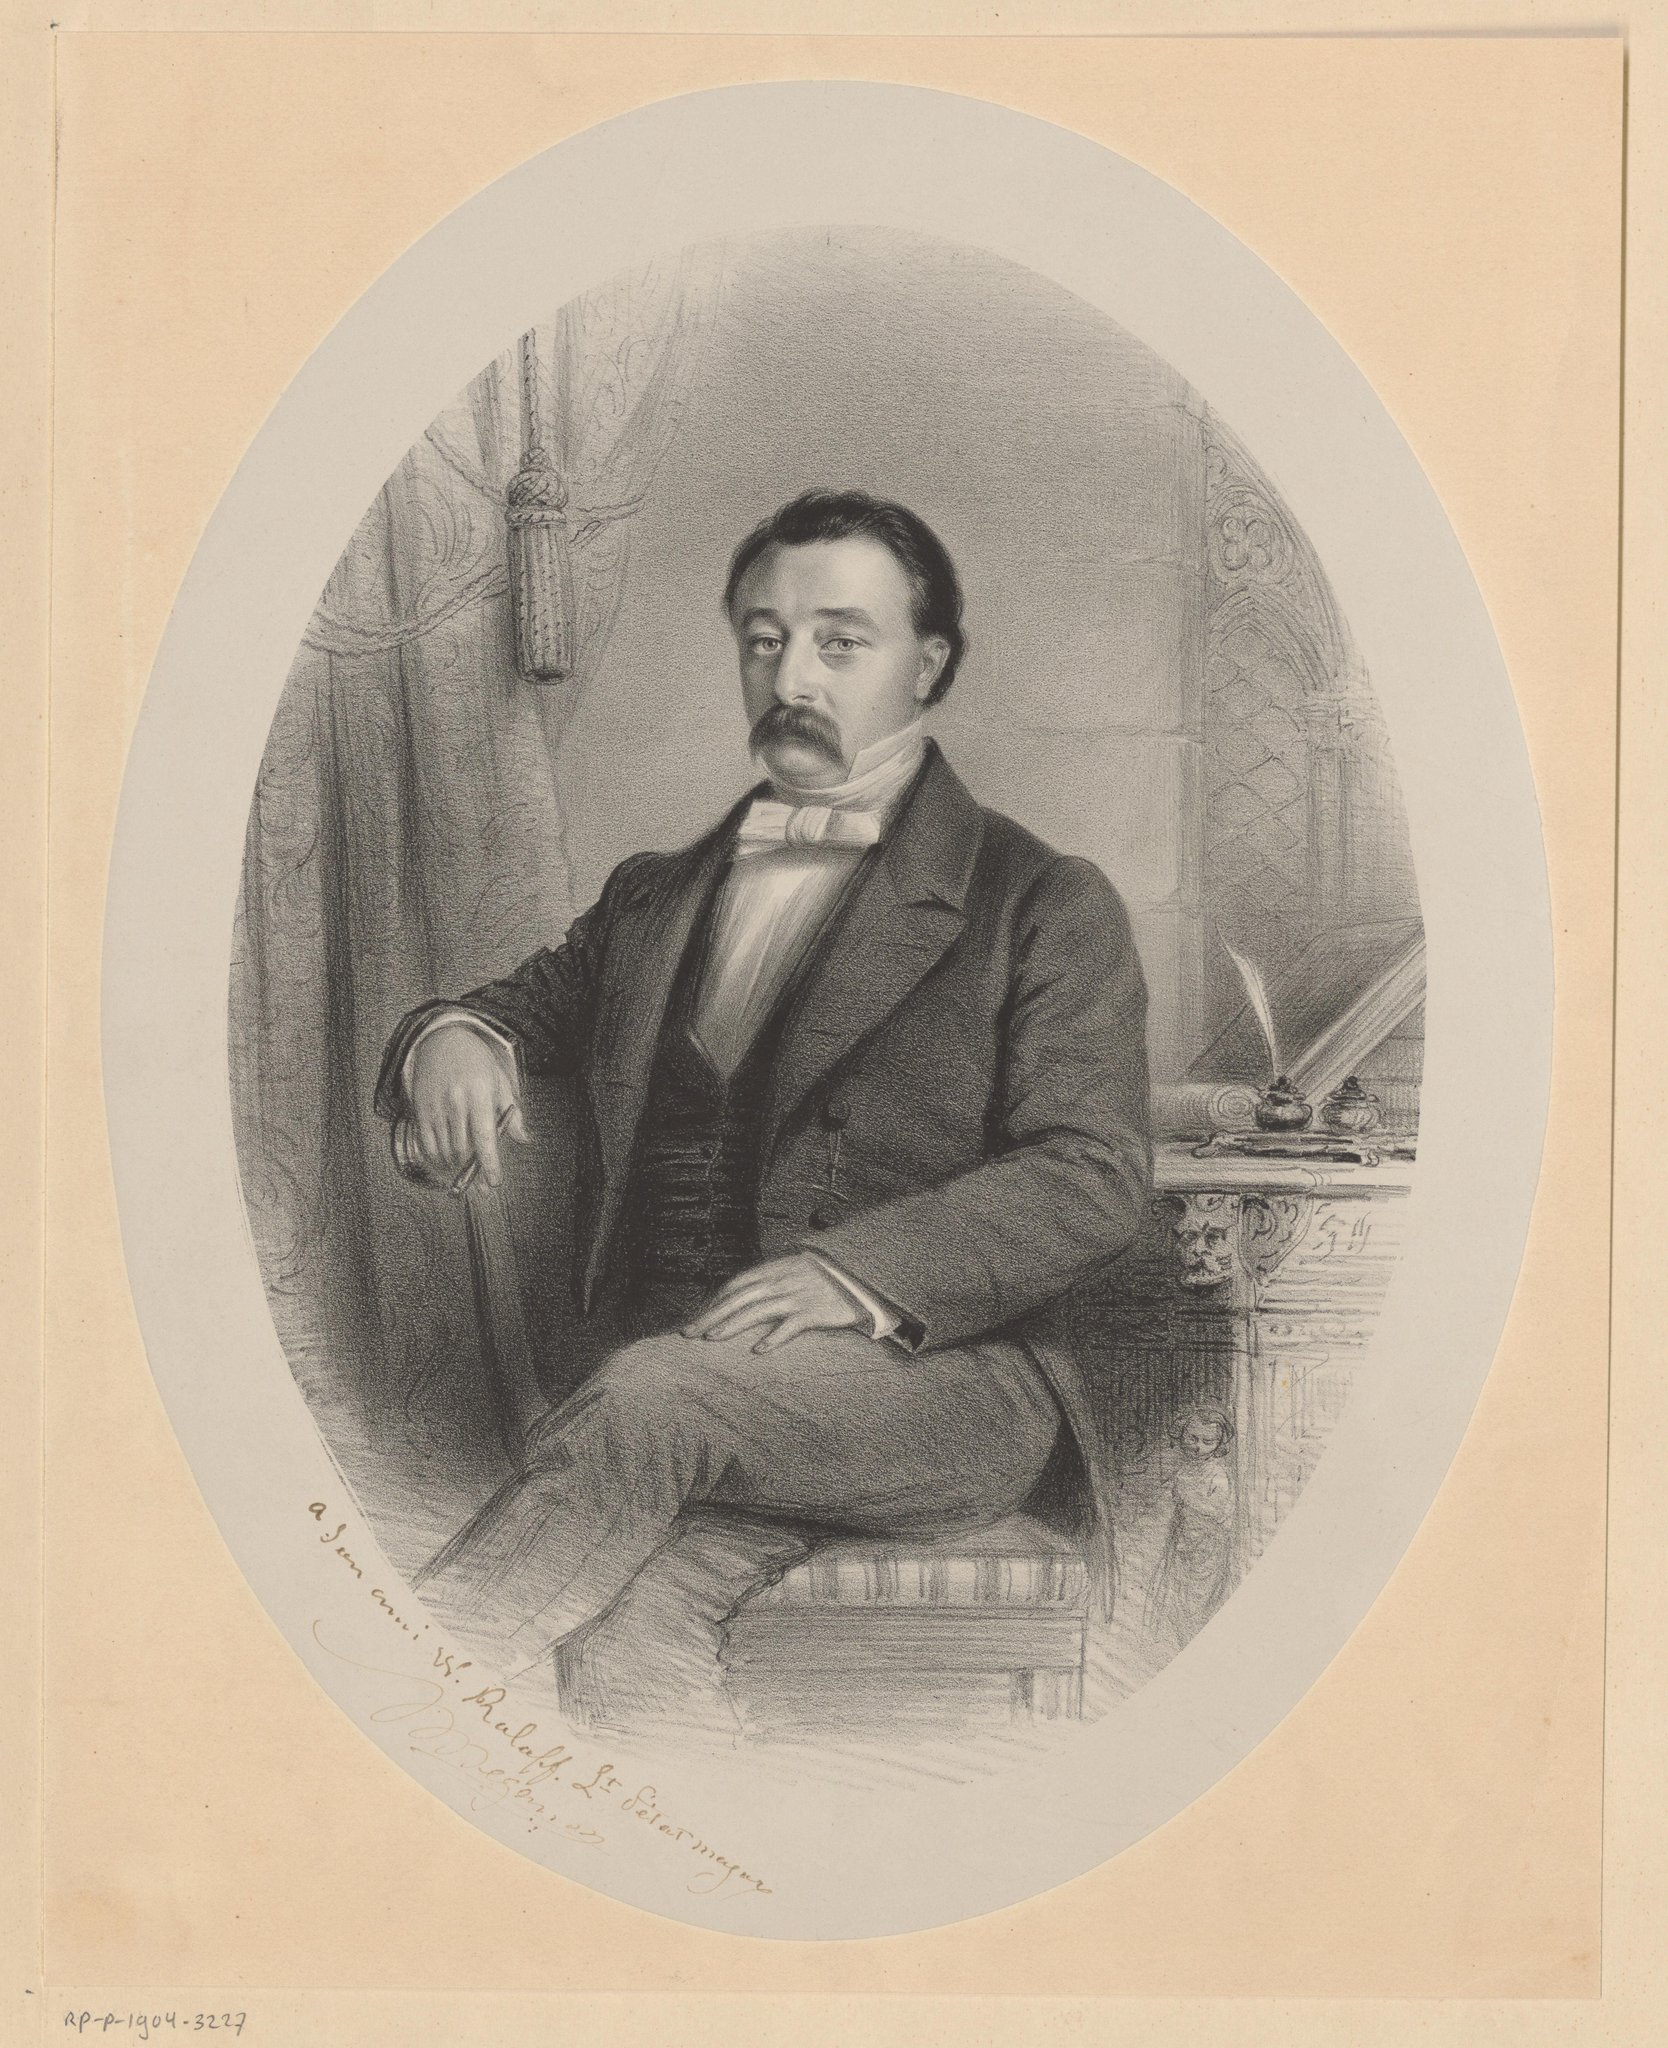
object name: print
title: Portret van een onbekende man aan een schrijftafel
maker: adrianus johannes ehnle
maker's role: draughtsman, print maker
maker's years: 1819-1863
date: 1829-1863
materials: paper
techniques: lithograph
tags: writing-table, writing-desk, cigar, anonymous historical person portrayed alone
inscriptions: collector's mark: Lugt 2228, inscription: ‘a son ami W. Roloff Lt. d'état mayor[?]/ VMegen[?]’